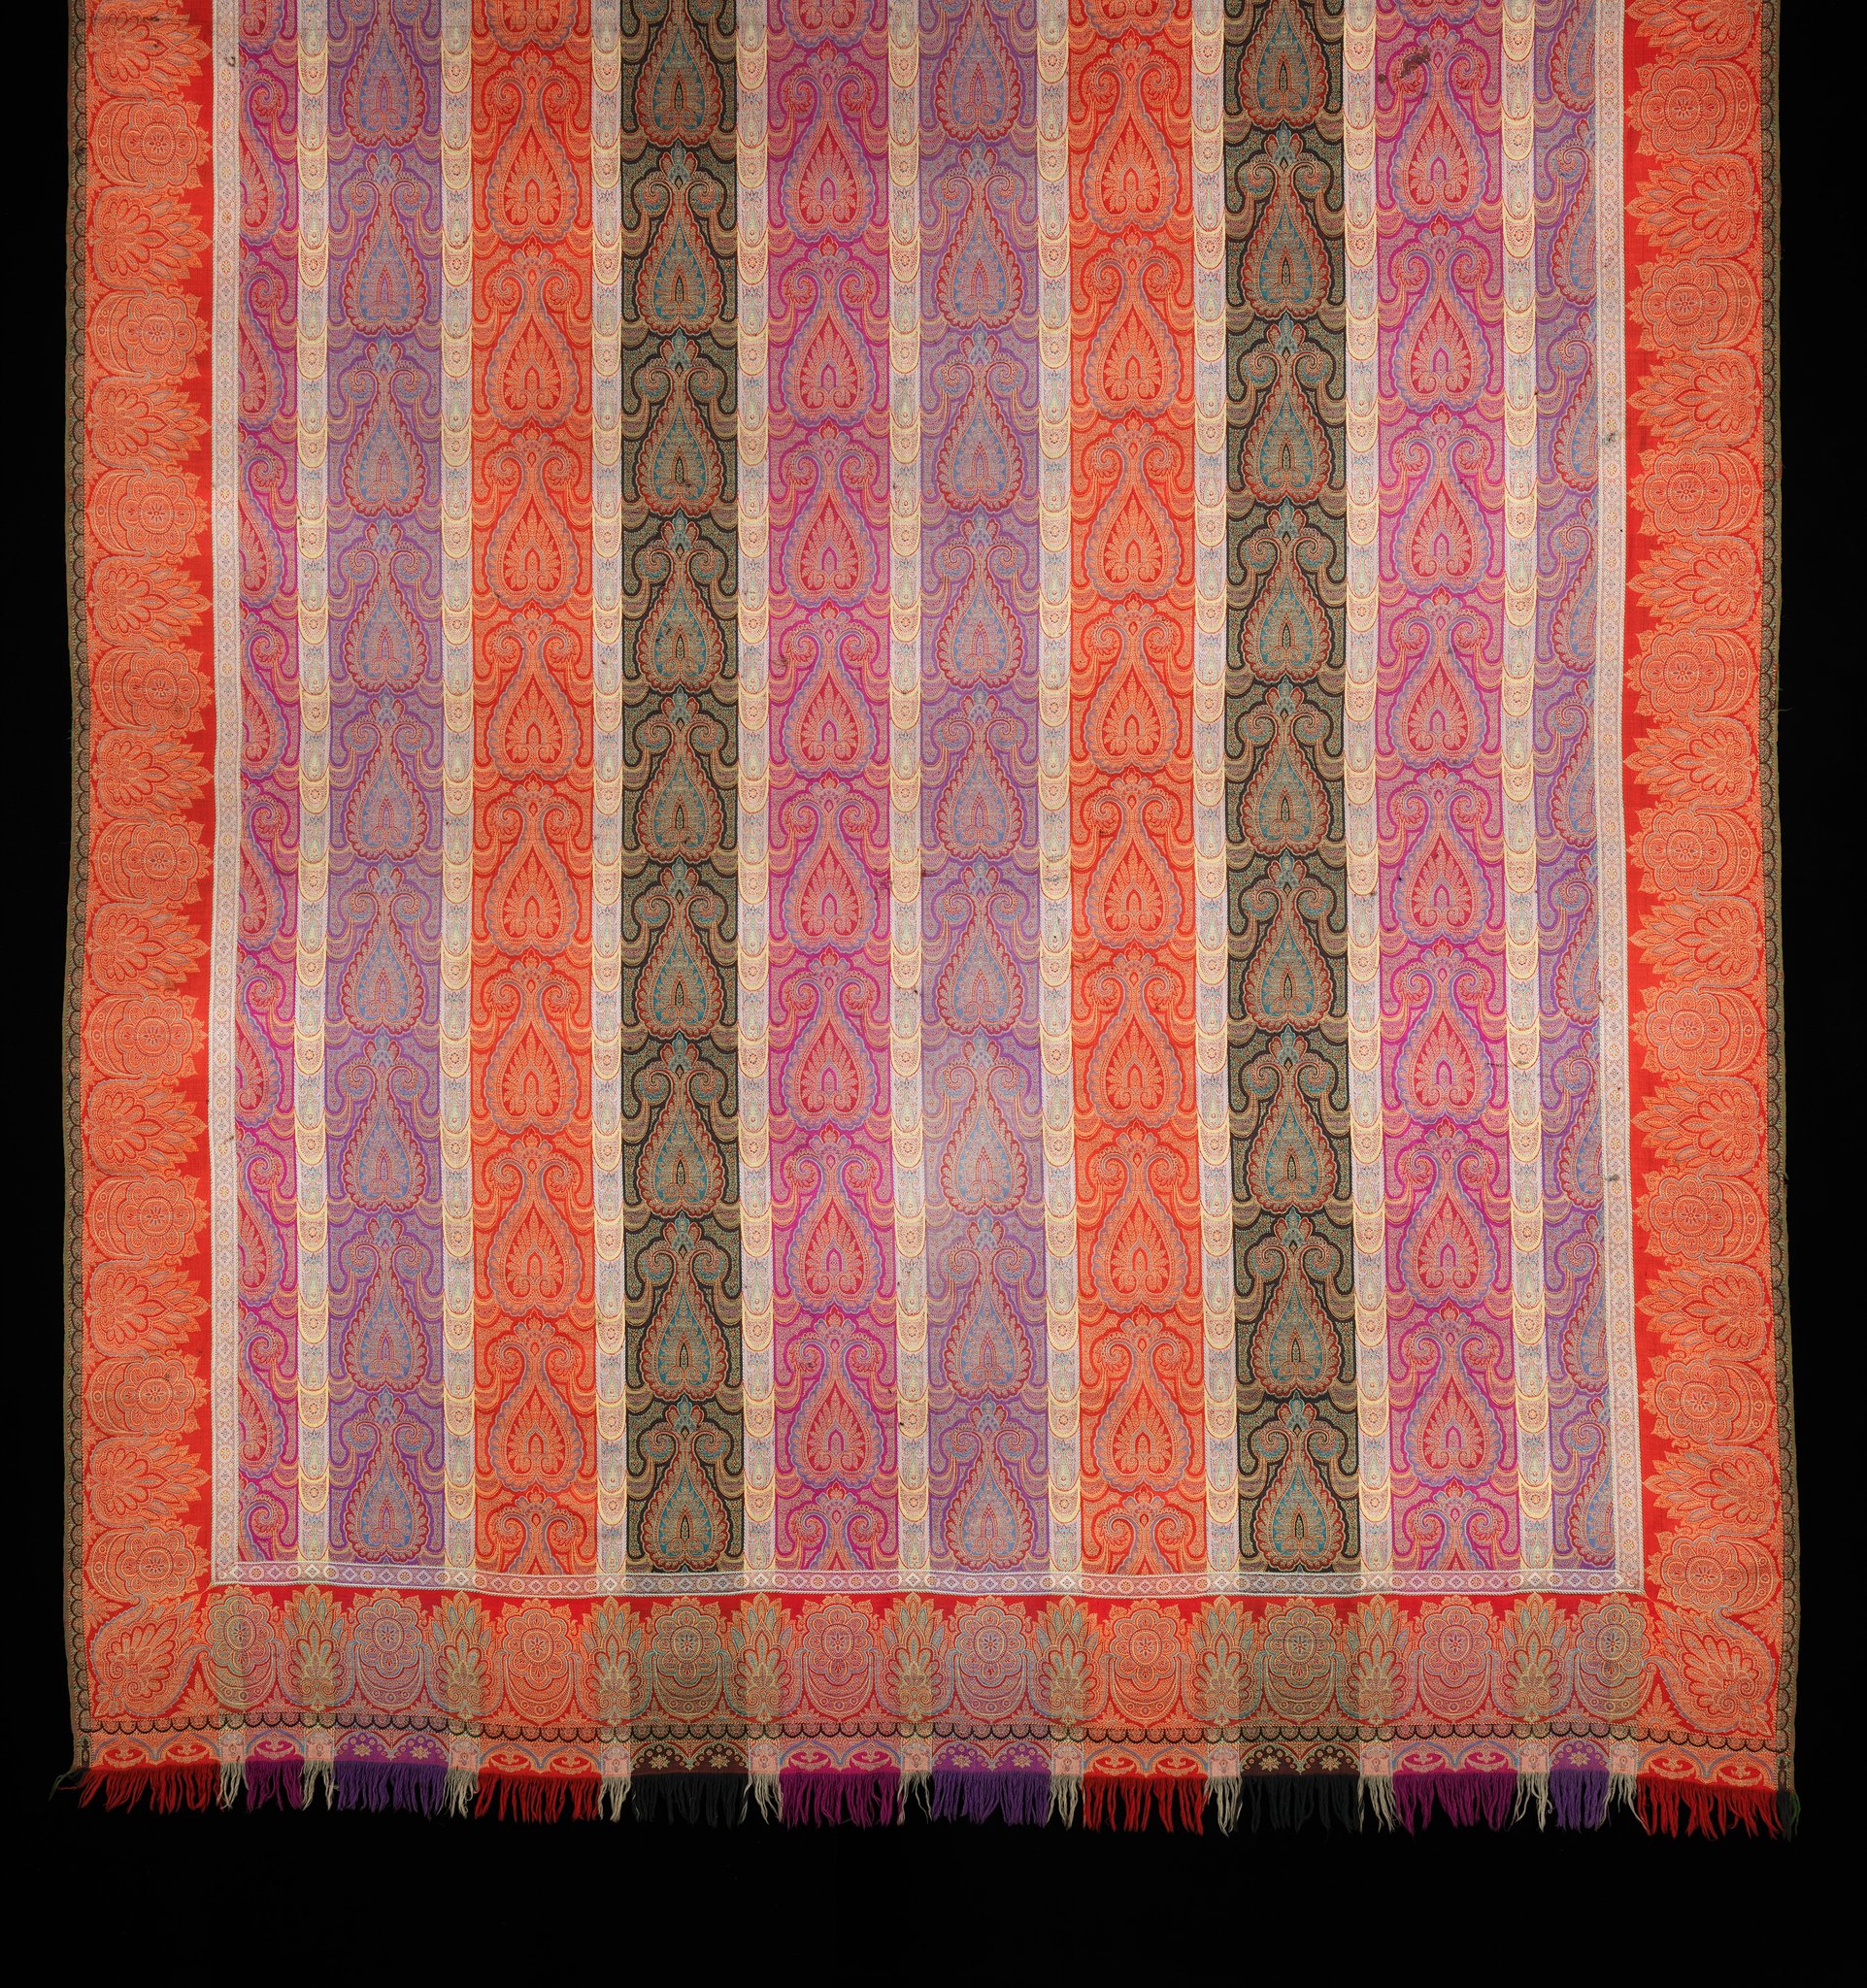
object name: shawl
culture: french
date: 1860-1875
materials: silk, wool